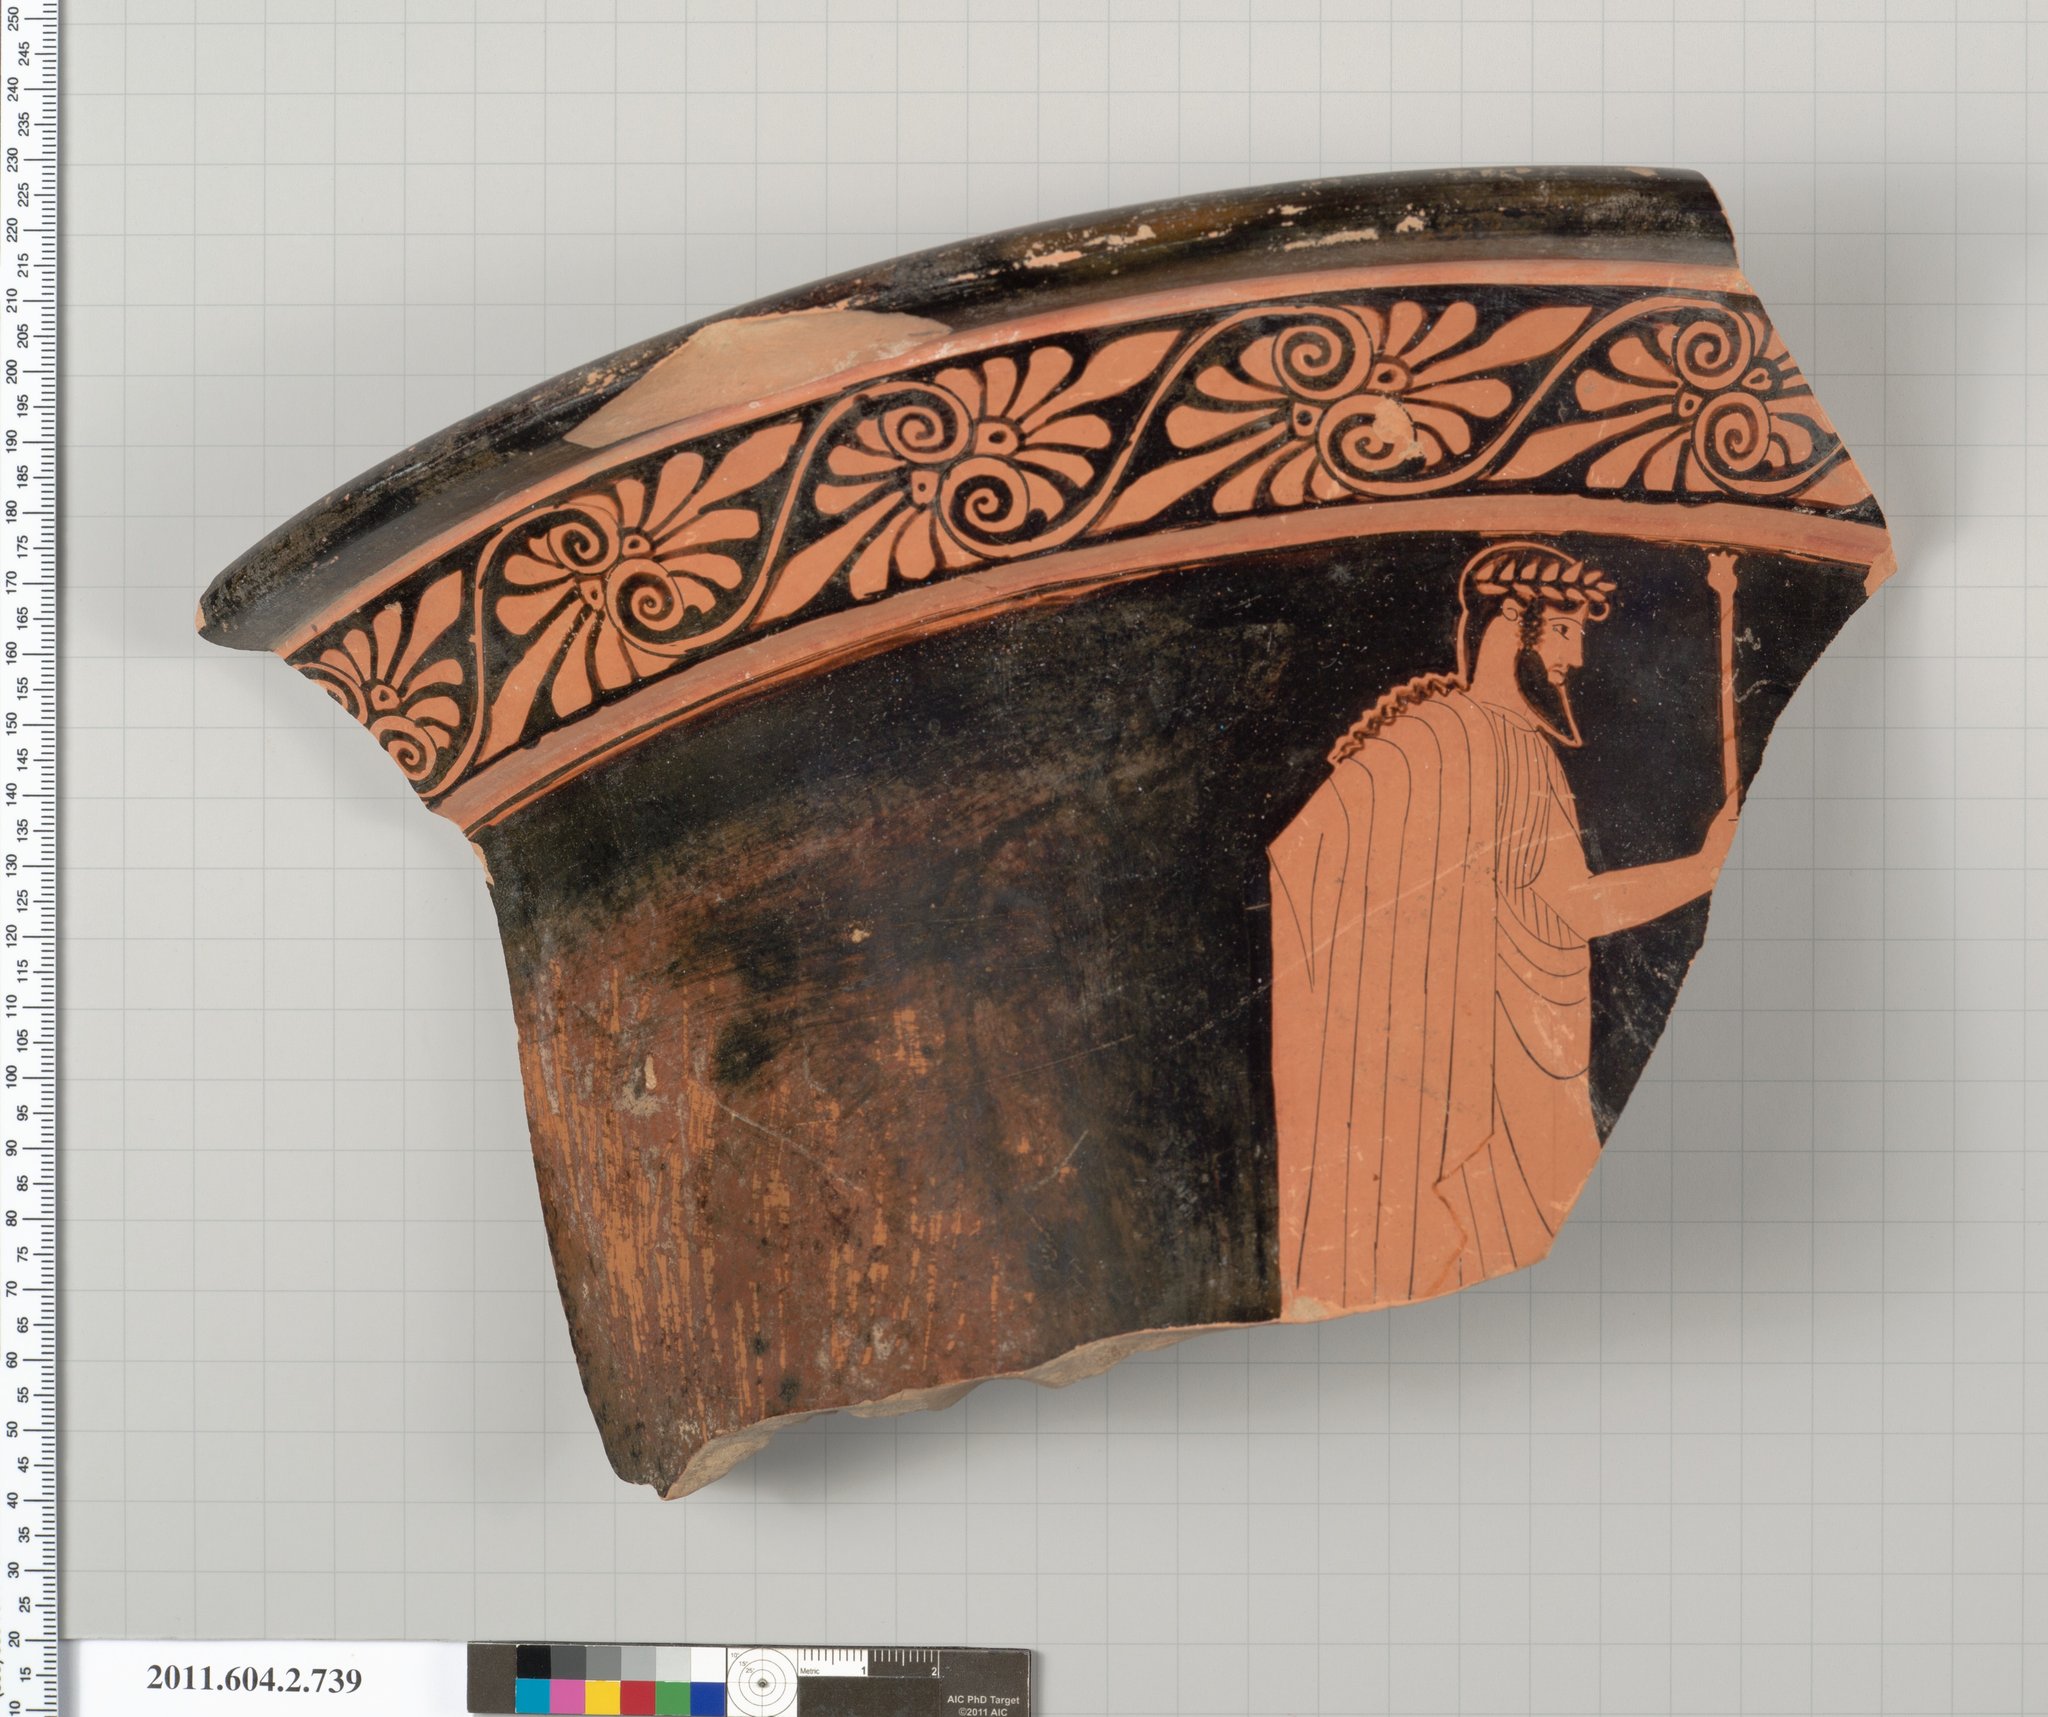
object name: calyx krater fragment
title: Terracotta fragment of a calyx-krater (bowl for mixing wine and water)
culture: greek, attic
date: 460-450 BCE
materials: terracotta